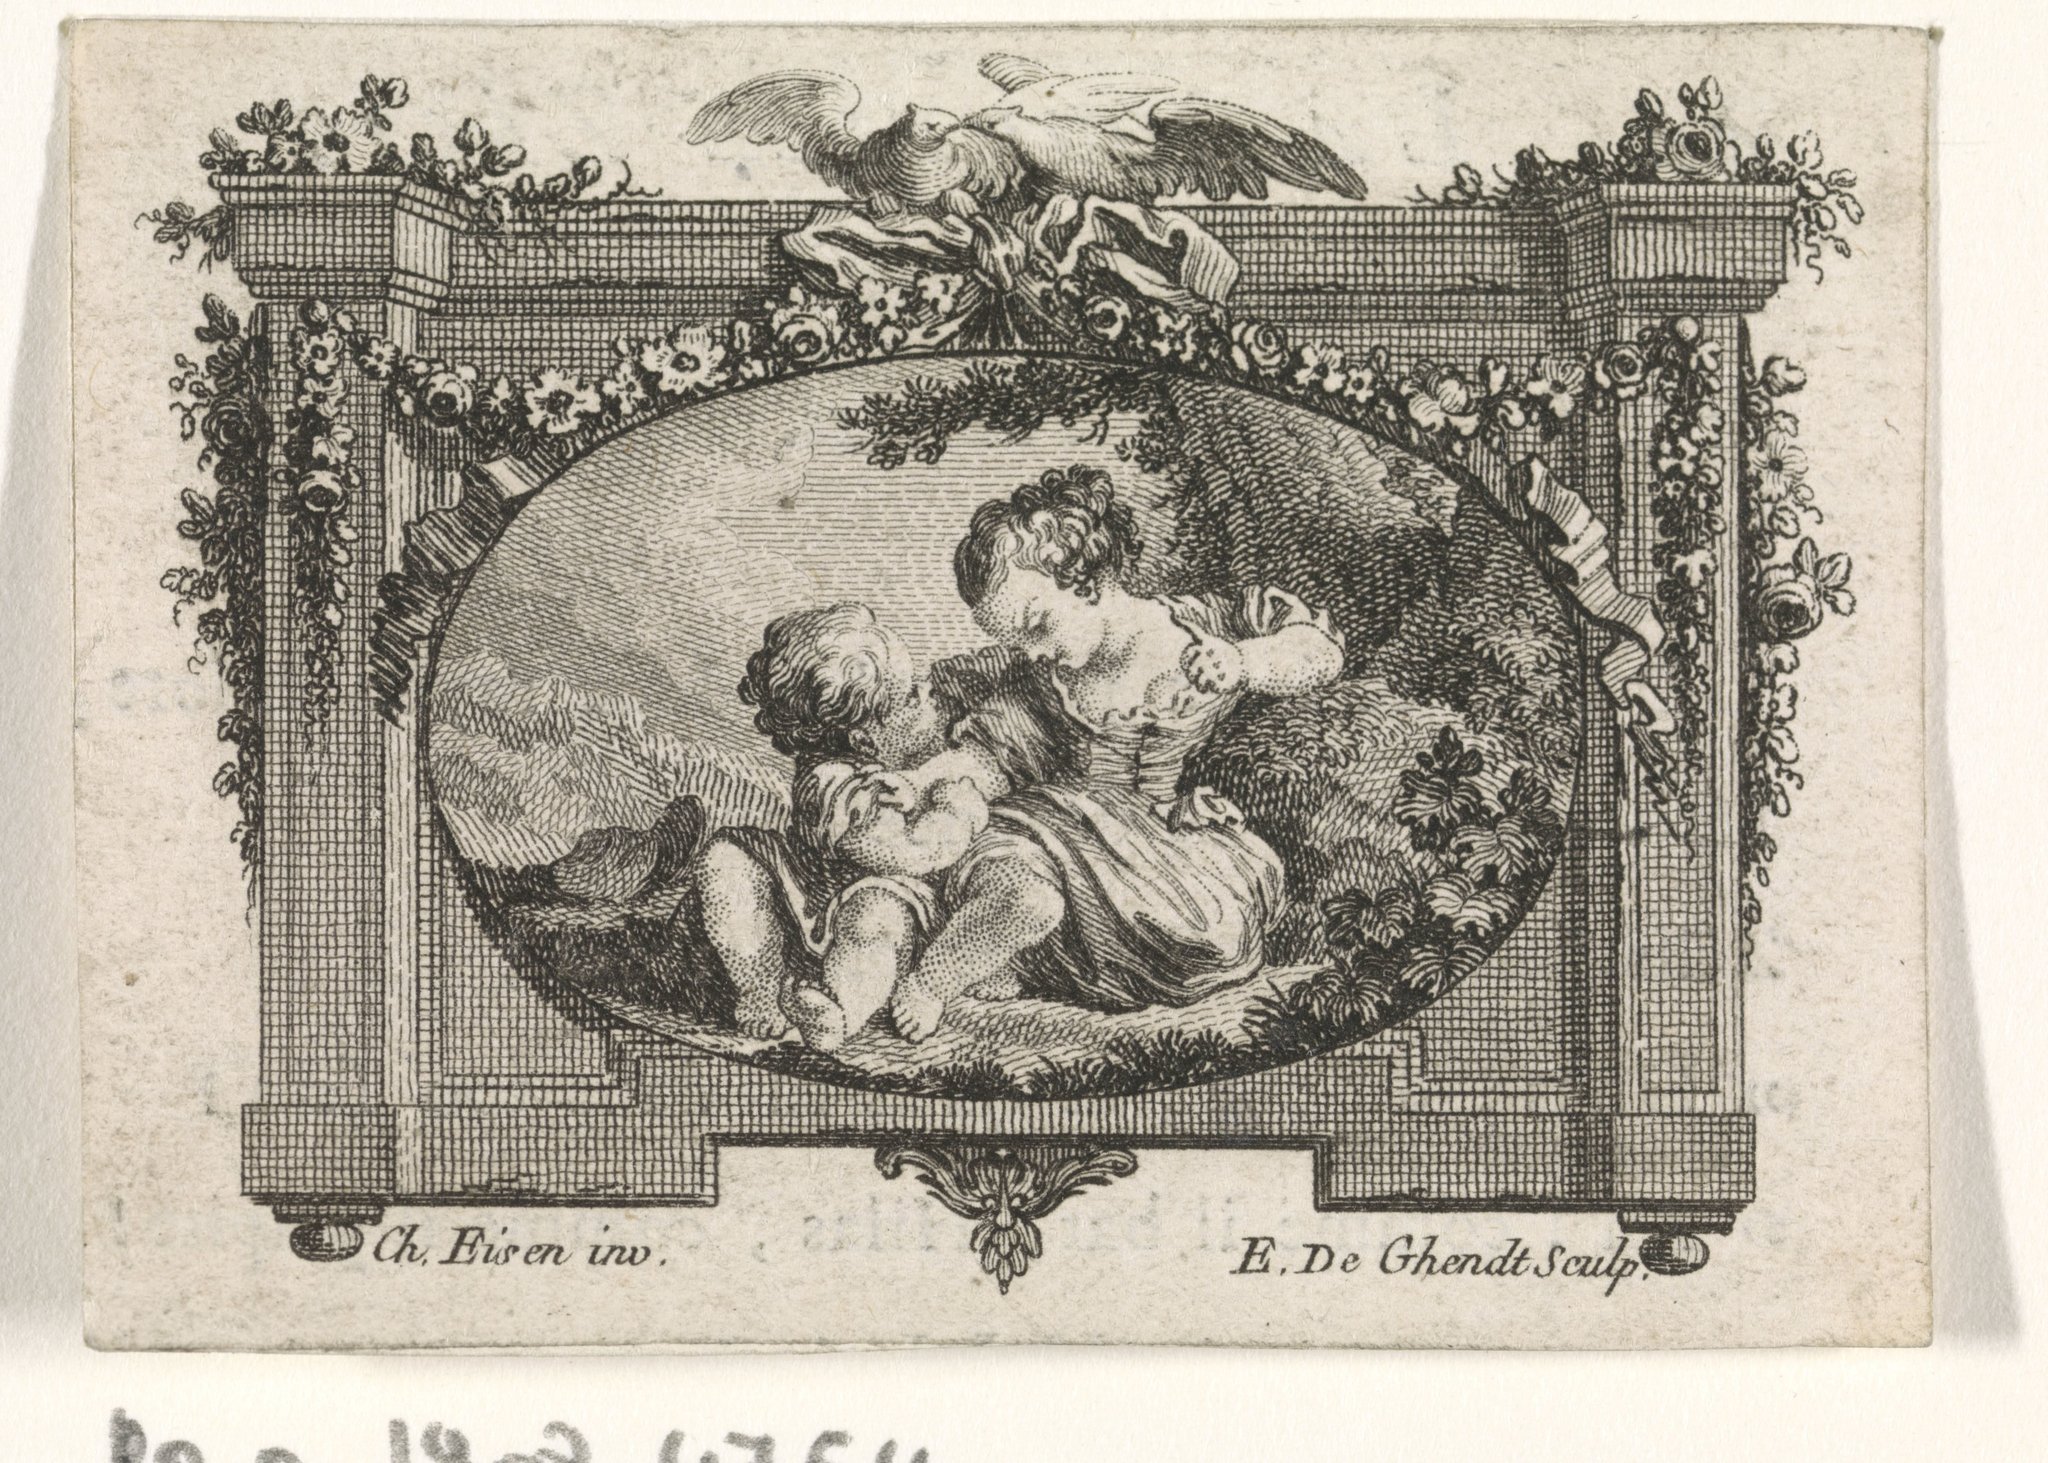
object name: print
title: Meisje en een putto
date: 1771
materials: paper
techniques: etching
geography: paris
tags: girl (child between toddler and youth), cupids: 'amores', 'amoretti', 'putti' (+ aggressive, unfriendly activities and relationships)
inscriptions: collector's mark: Lugt 2228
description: Boekillustratie voor M. Leonard, "Poësies pastorales", Parijs en Geneve 1771.